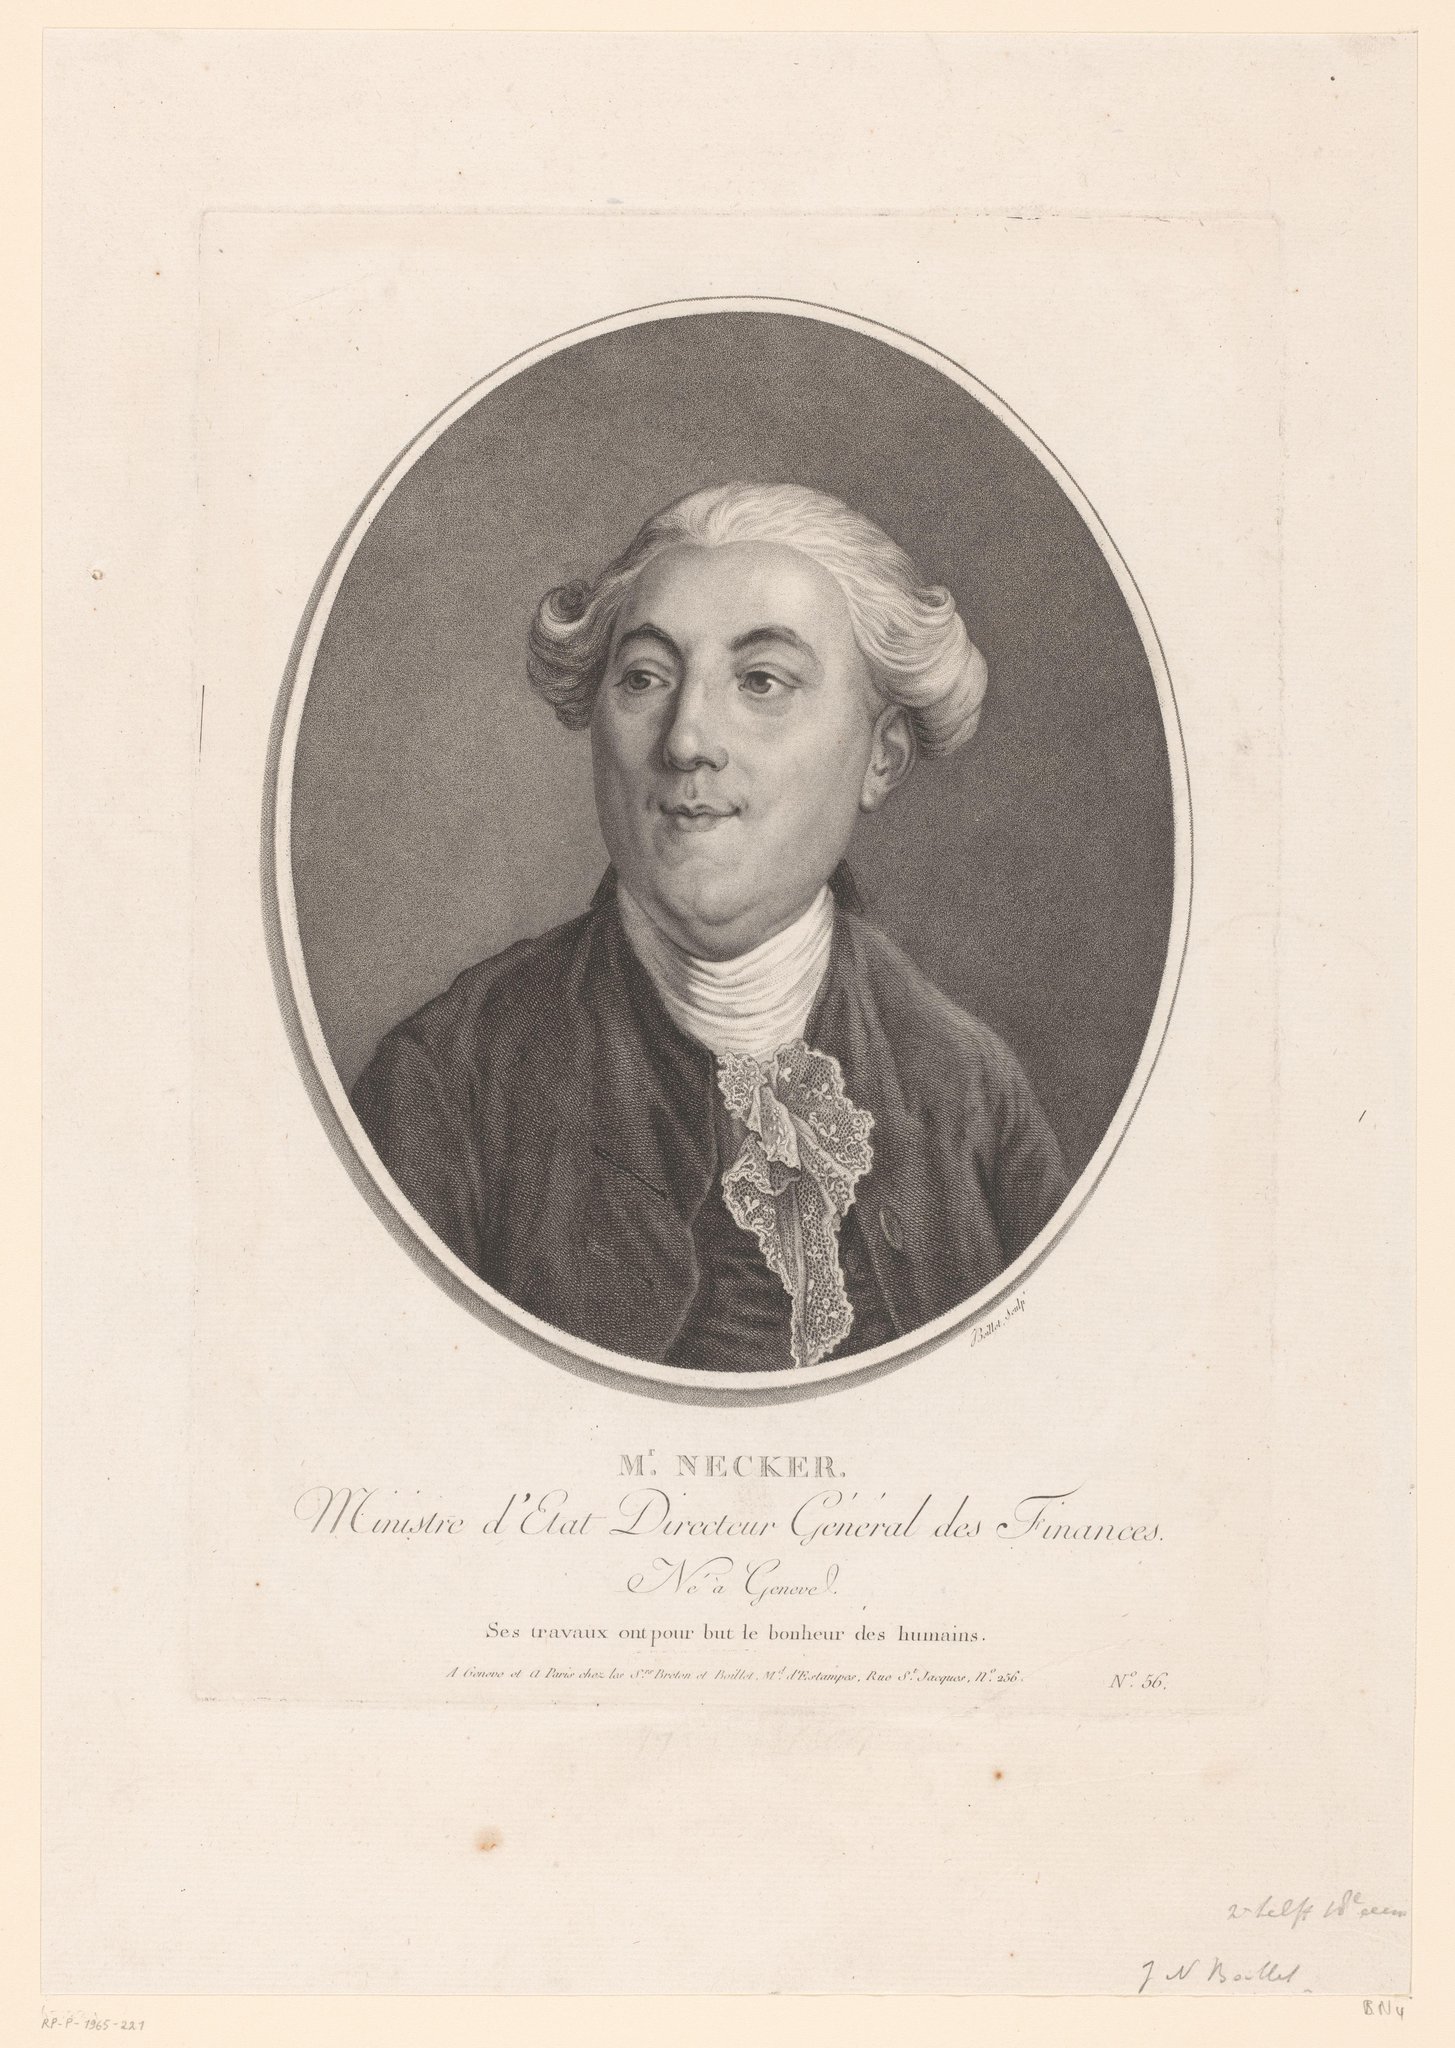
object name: print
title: Mr. Necker.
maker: j.n. boillet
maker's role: print maker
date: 1789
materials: paper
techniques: etching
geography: france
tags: ornament ~ medallion, historical persons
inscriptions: collector's mark: Lugt 2228